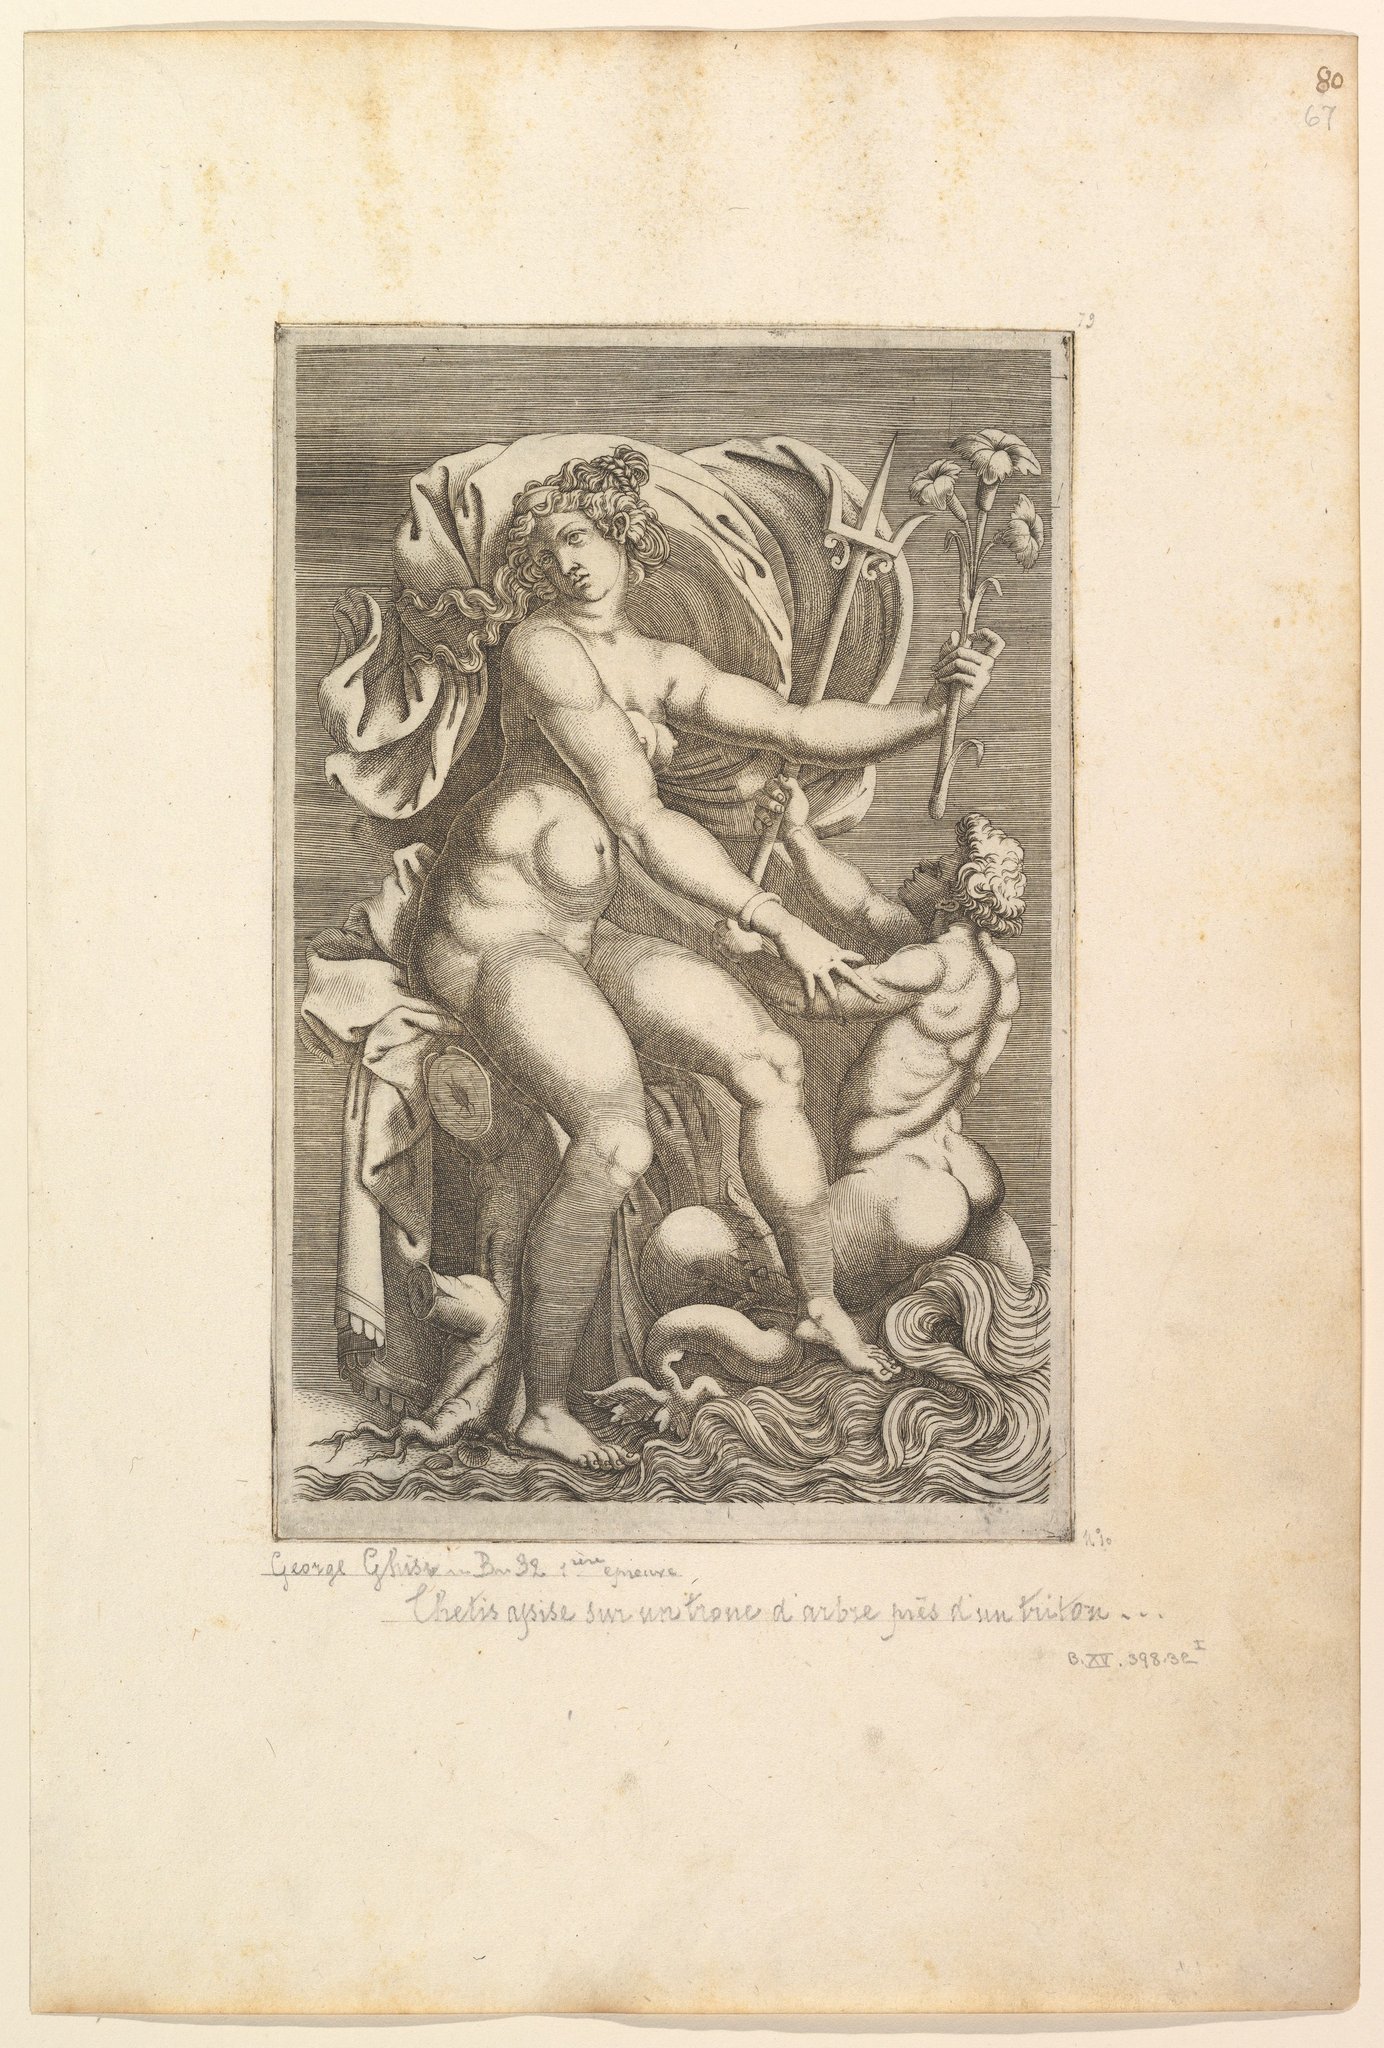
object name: print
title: Thetis Seated with a Triton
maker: anonymous, italian?, 16th century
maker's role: artist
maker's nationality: italian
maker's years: 1500-1600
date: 1501-1600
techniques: engraving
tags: weapons,triton,flowers,goddess